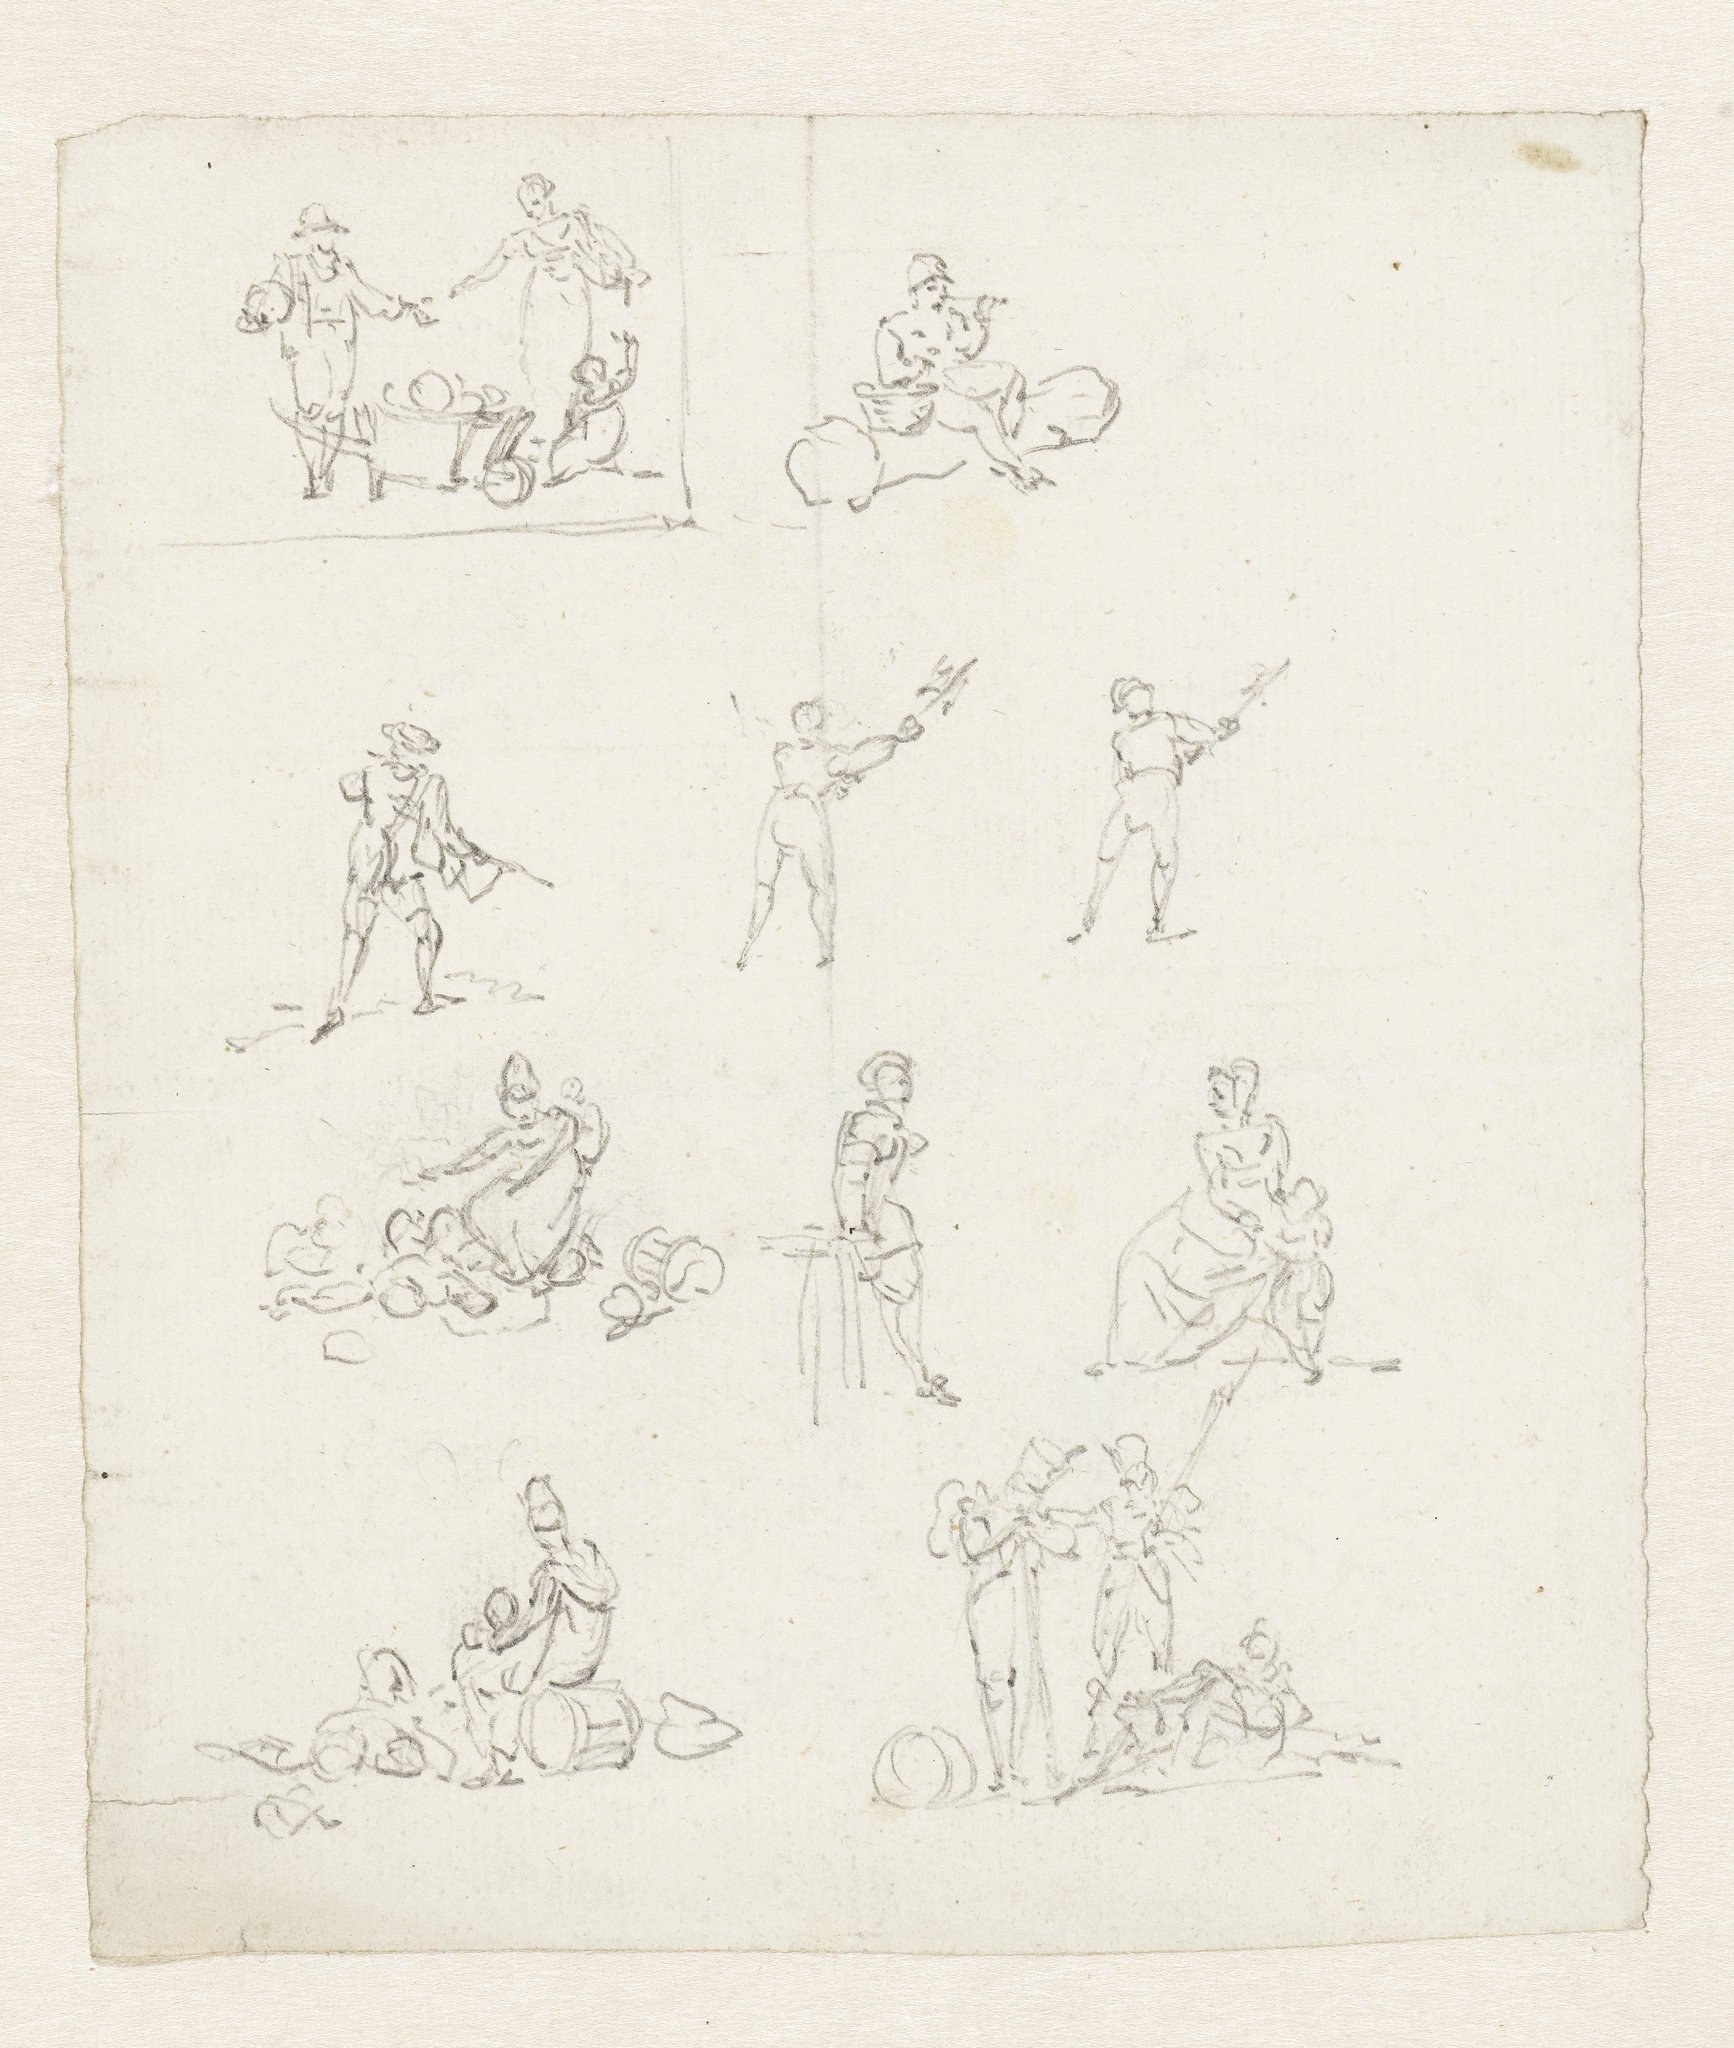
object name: drawing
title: Studies van soldaten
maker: pieter bartholomeusz. barbiers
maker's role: draughtsman, print maker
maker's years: 1772-1837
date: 1782-1837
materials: graphite, paper